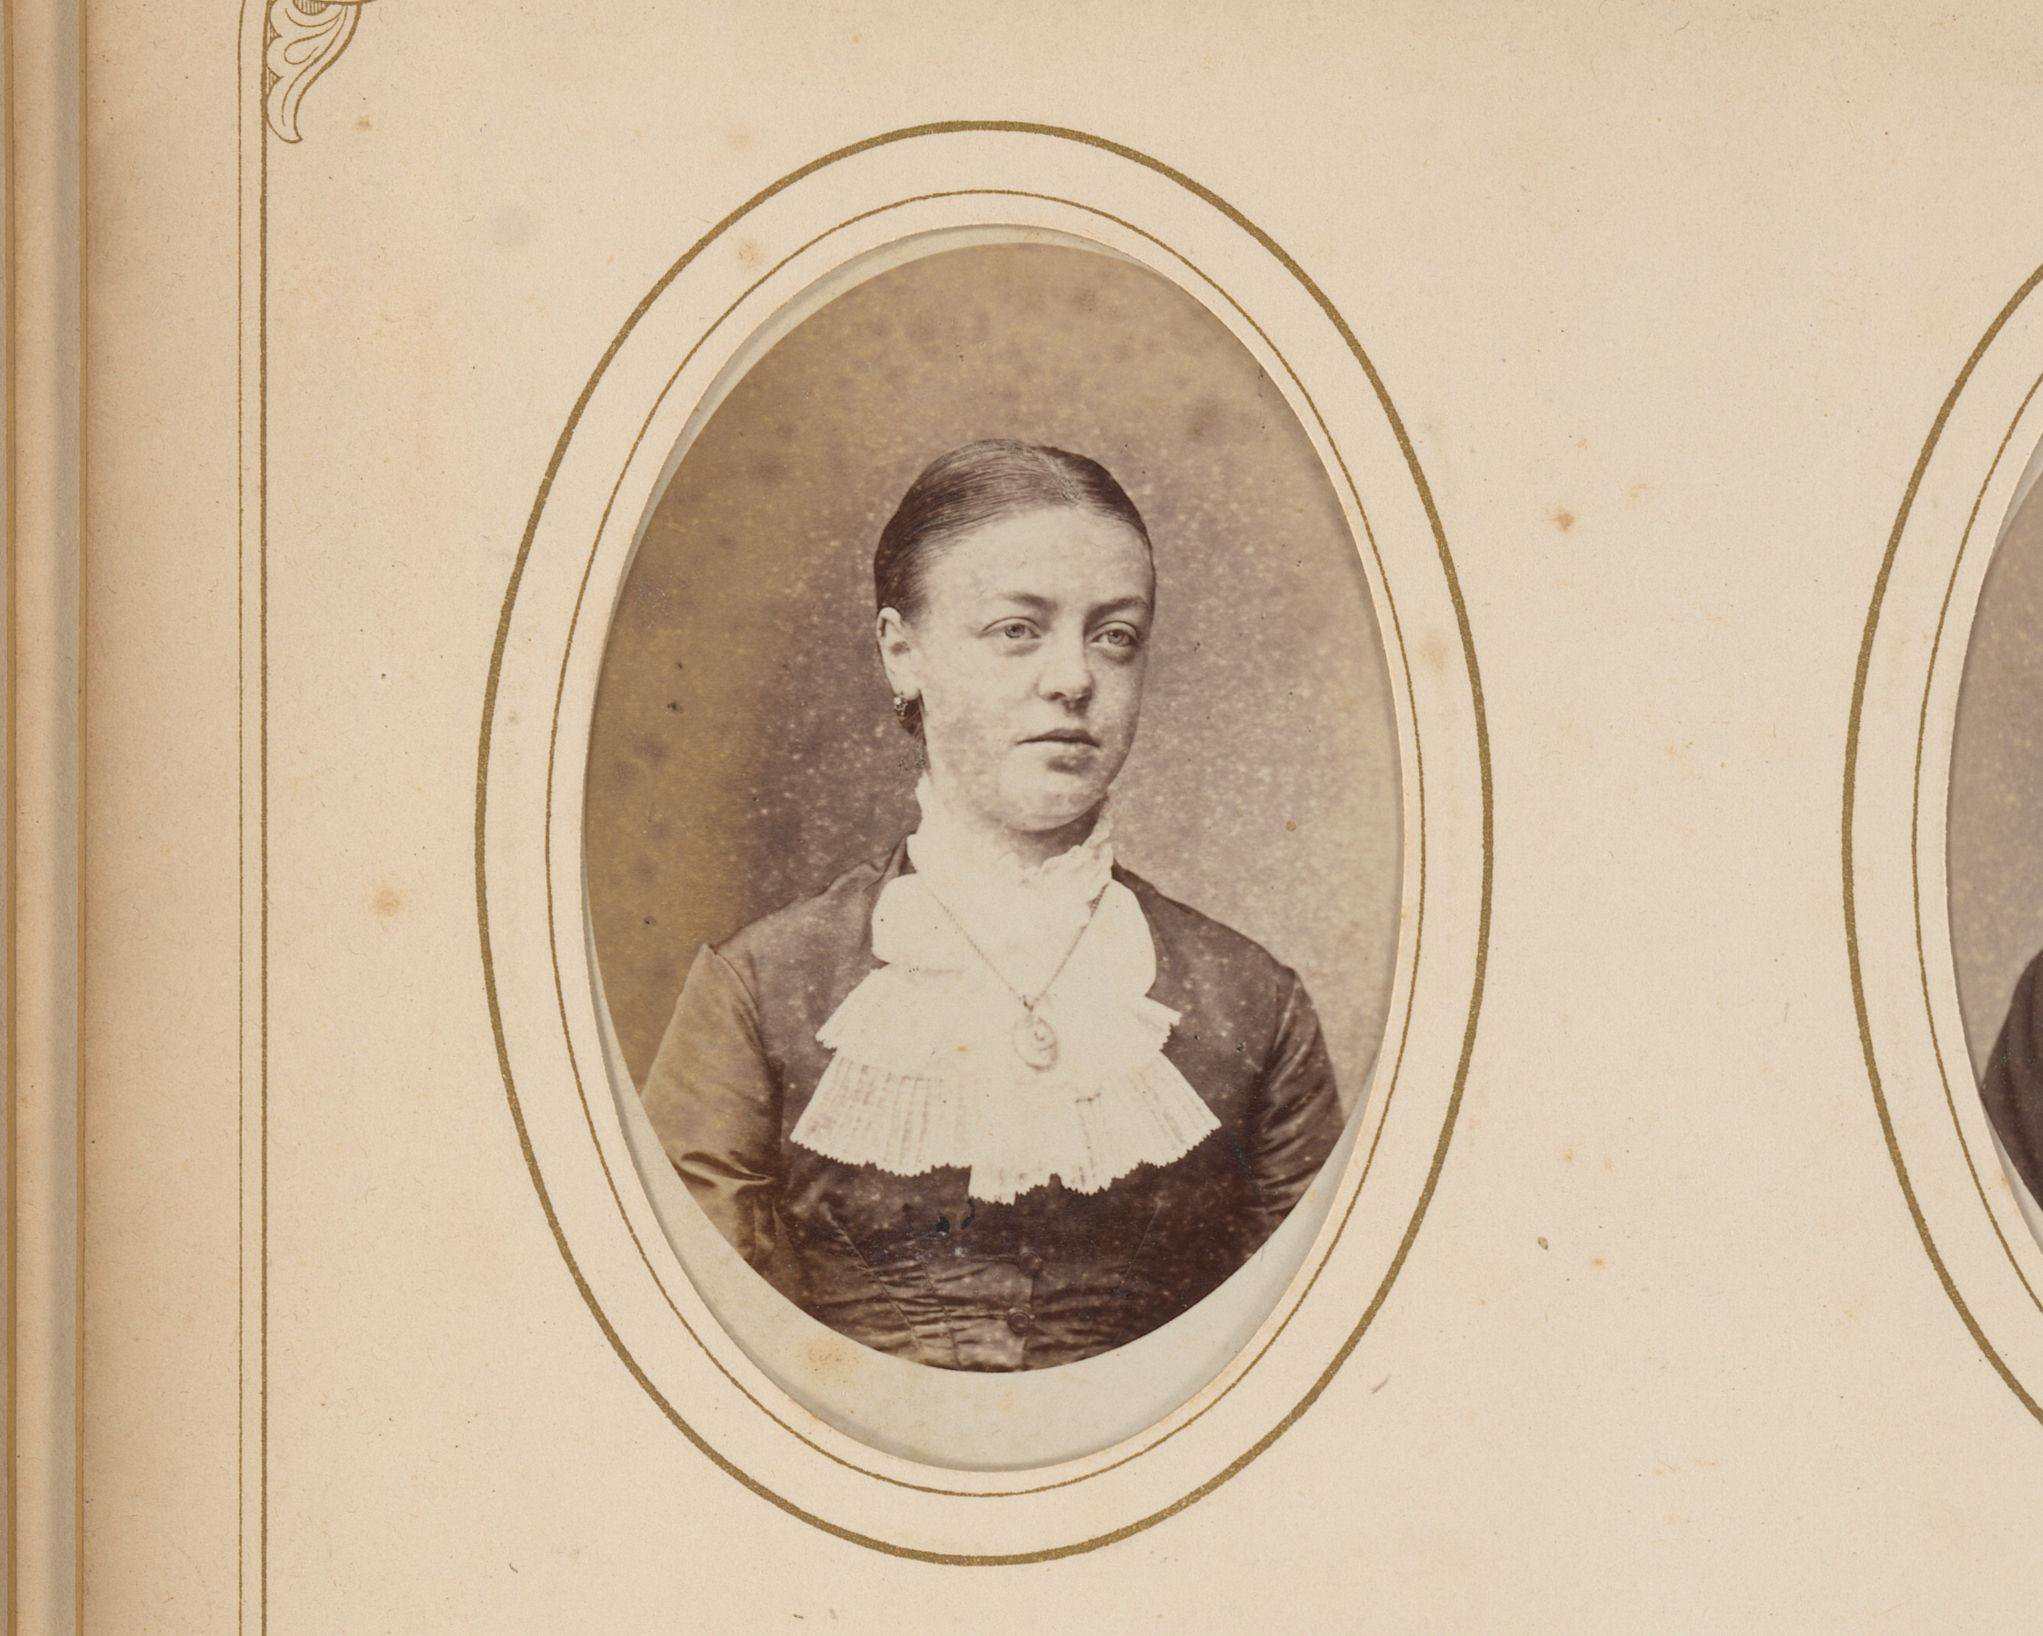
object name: carte de visite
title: Portret van een jonge vrouw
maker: franz weisbrod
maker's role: fotograaf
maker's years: -1873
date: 1860-1870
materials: cardboard, photographic support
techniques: albumen print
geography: frankfurt am main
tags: adolescent, young woman, maiden, historical persons - bb - woman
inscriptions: inscription: ‘F. Weisbrod/ Bleichstrasse 70./ am Eschenheimer Thor/ FRANKFURT a/ Main.’